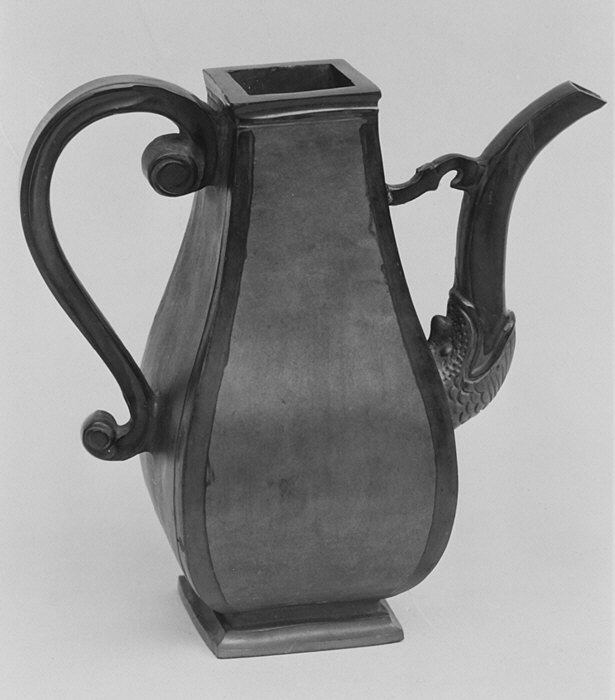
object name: coffeepot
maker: meissen manufactory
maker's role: manufactory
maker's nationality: german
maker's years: 1710-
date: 1710-1715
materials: stoneware